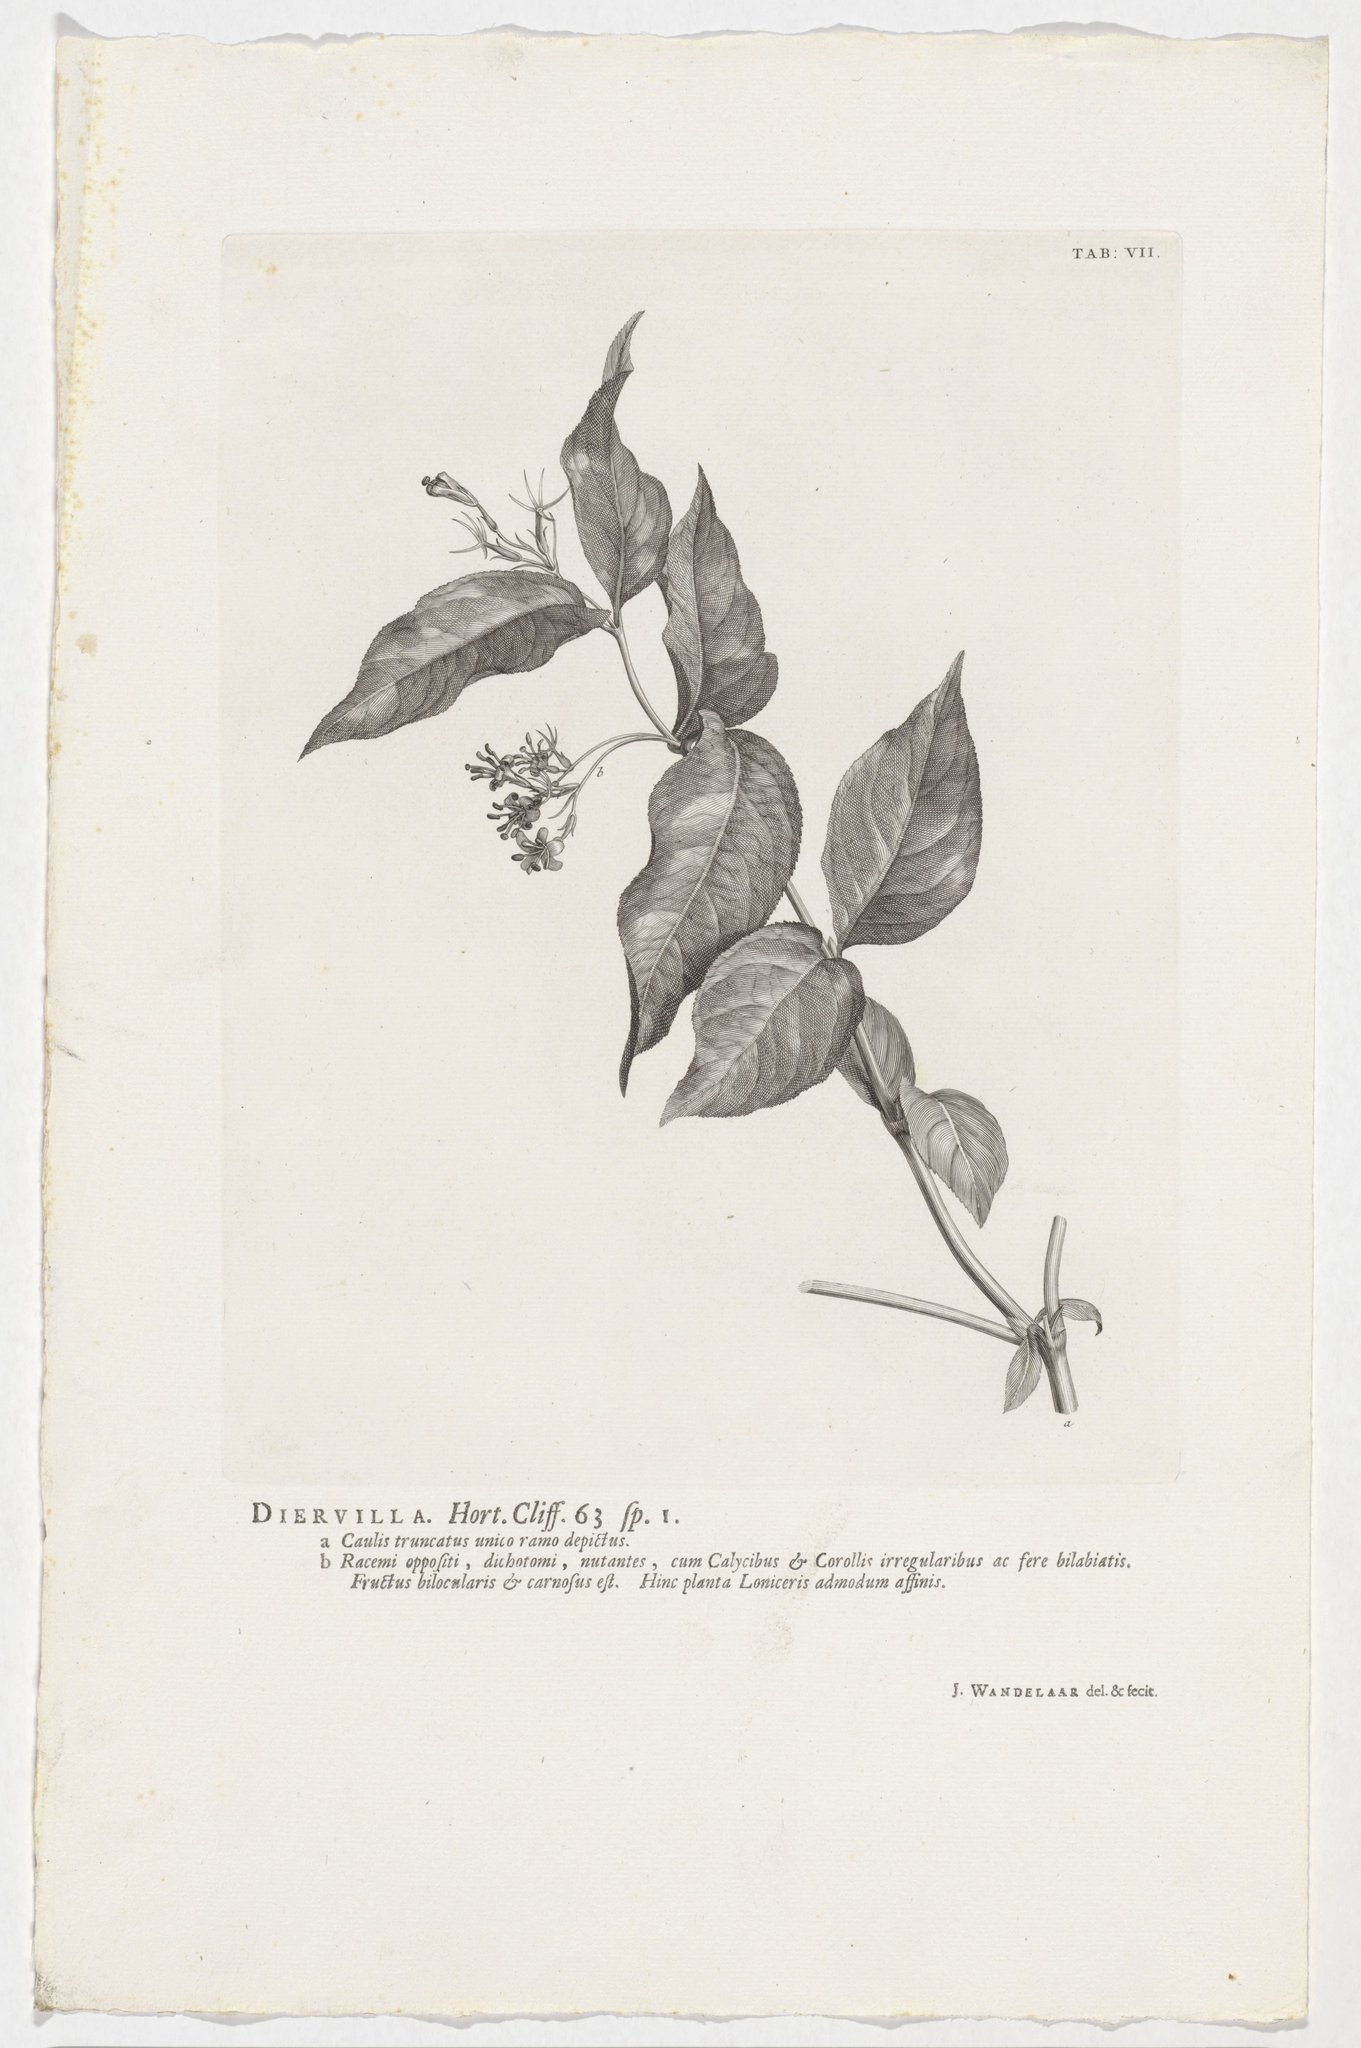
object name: print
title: Diervilla. Hort. Cliff. 63 sp. 1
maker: jan wandelaar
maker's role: draughtsman, print maker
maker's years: 1690-1759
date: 1738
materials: paper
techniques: etching, letterpress printing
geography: warmond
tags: flowers, plants and herbs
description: Prent gebruikt als illustratie in: Linnaeus, Carolus. Hortus Cliffortianus plantas exhibens quas in hortis tam vivis quam siccis, Hartecampi in Hollandia, coluit (...) Georgius Clifford. Amsterdam: sine nomen, 1738.